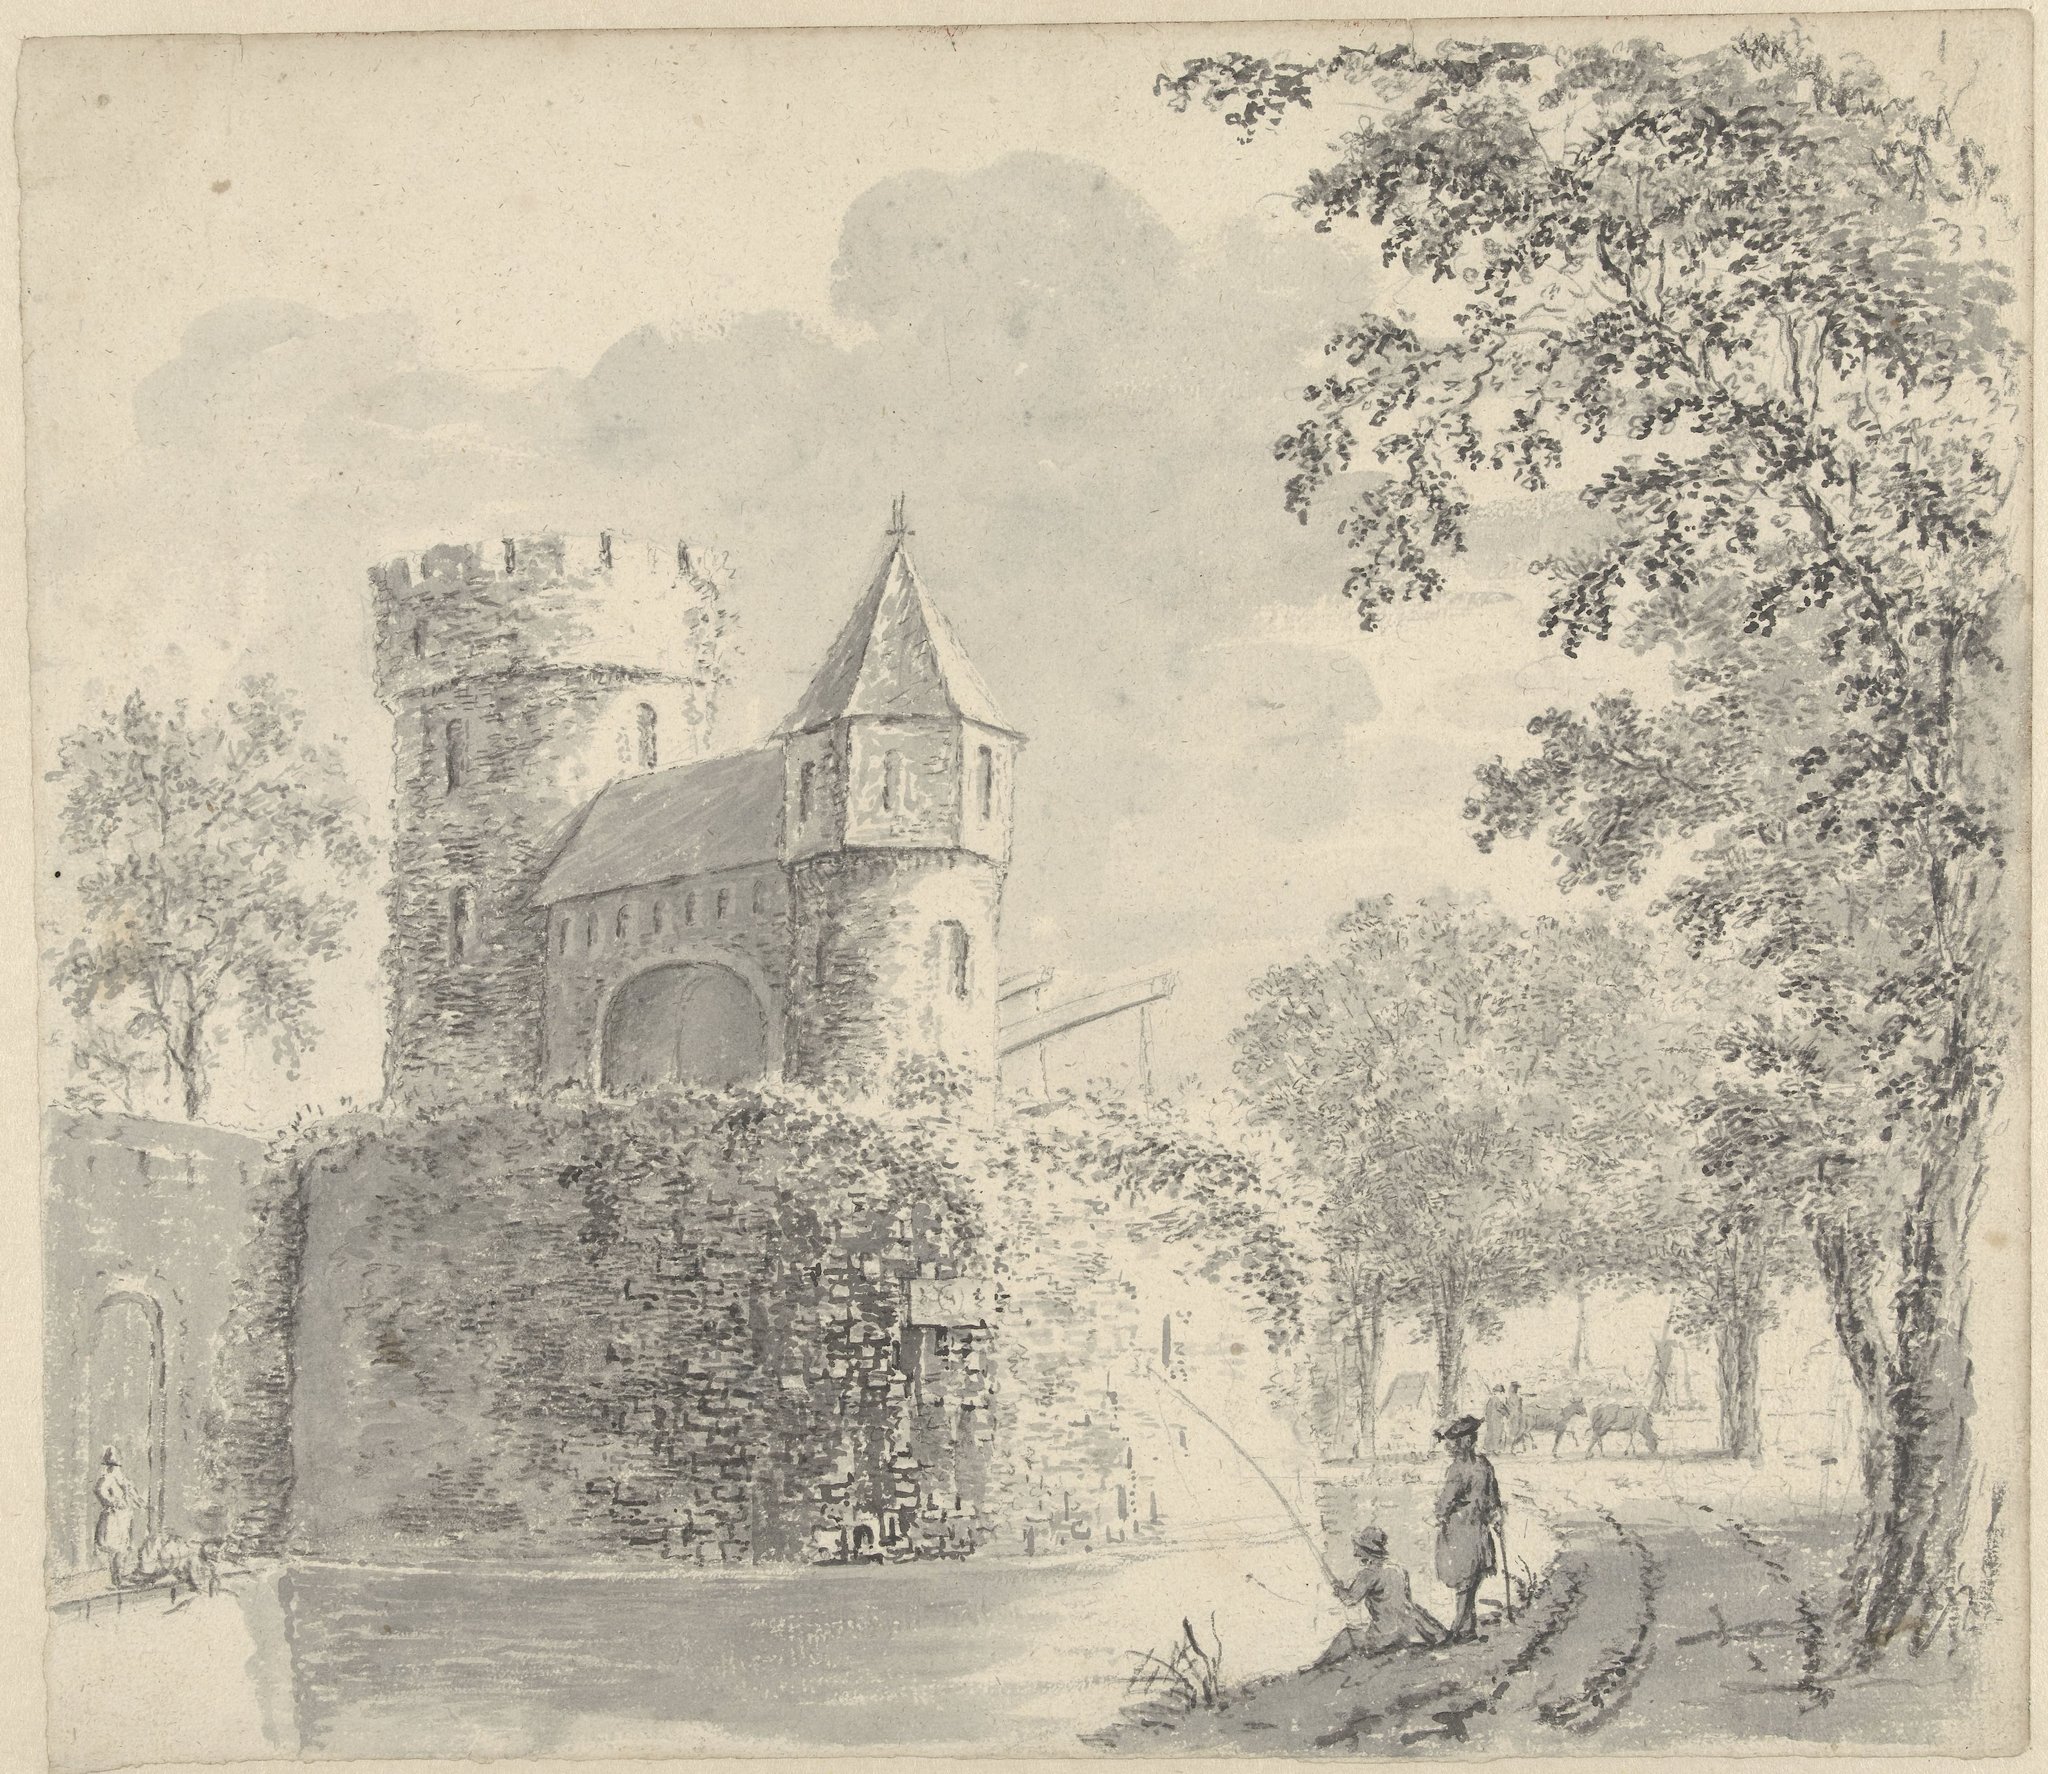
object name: drawing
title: Stadspoort en een visser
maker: Anonymous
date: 1700-1800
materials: ink, paper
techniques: brush, pen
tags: city-walls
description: Stadspoort en rechts op de voorgrond een visser in de stadsgracht.